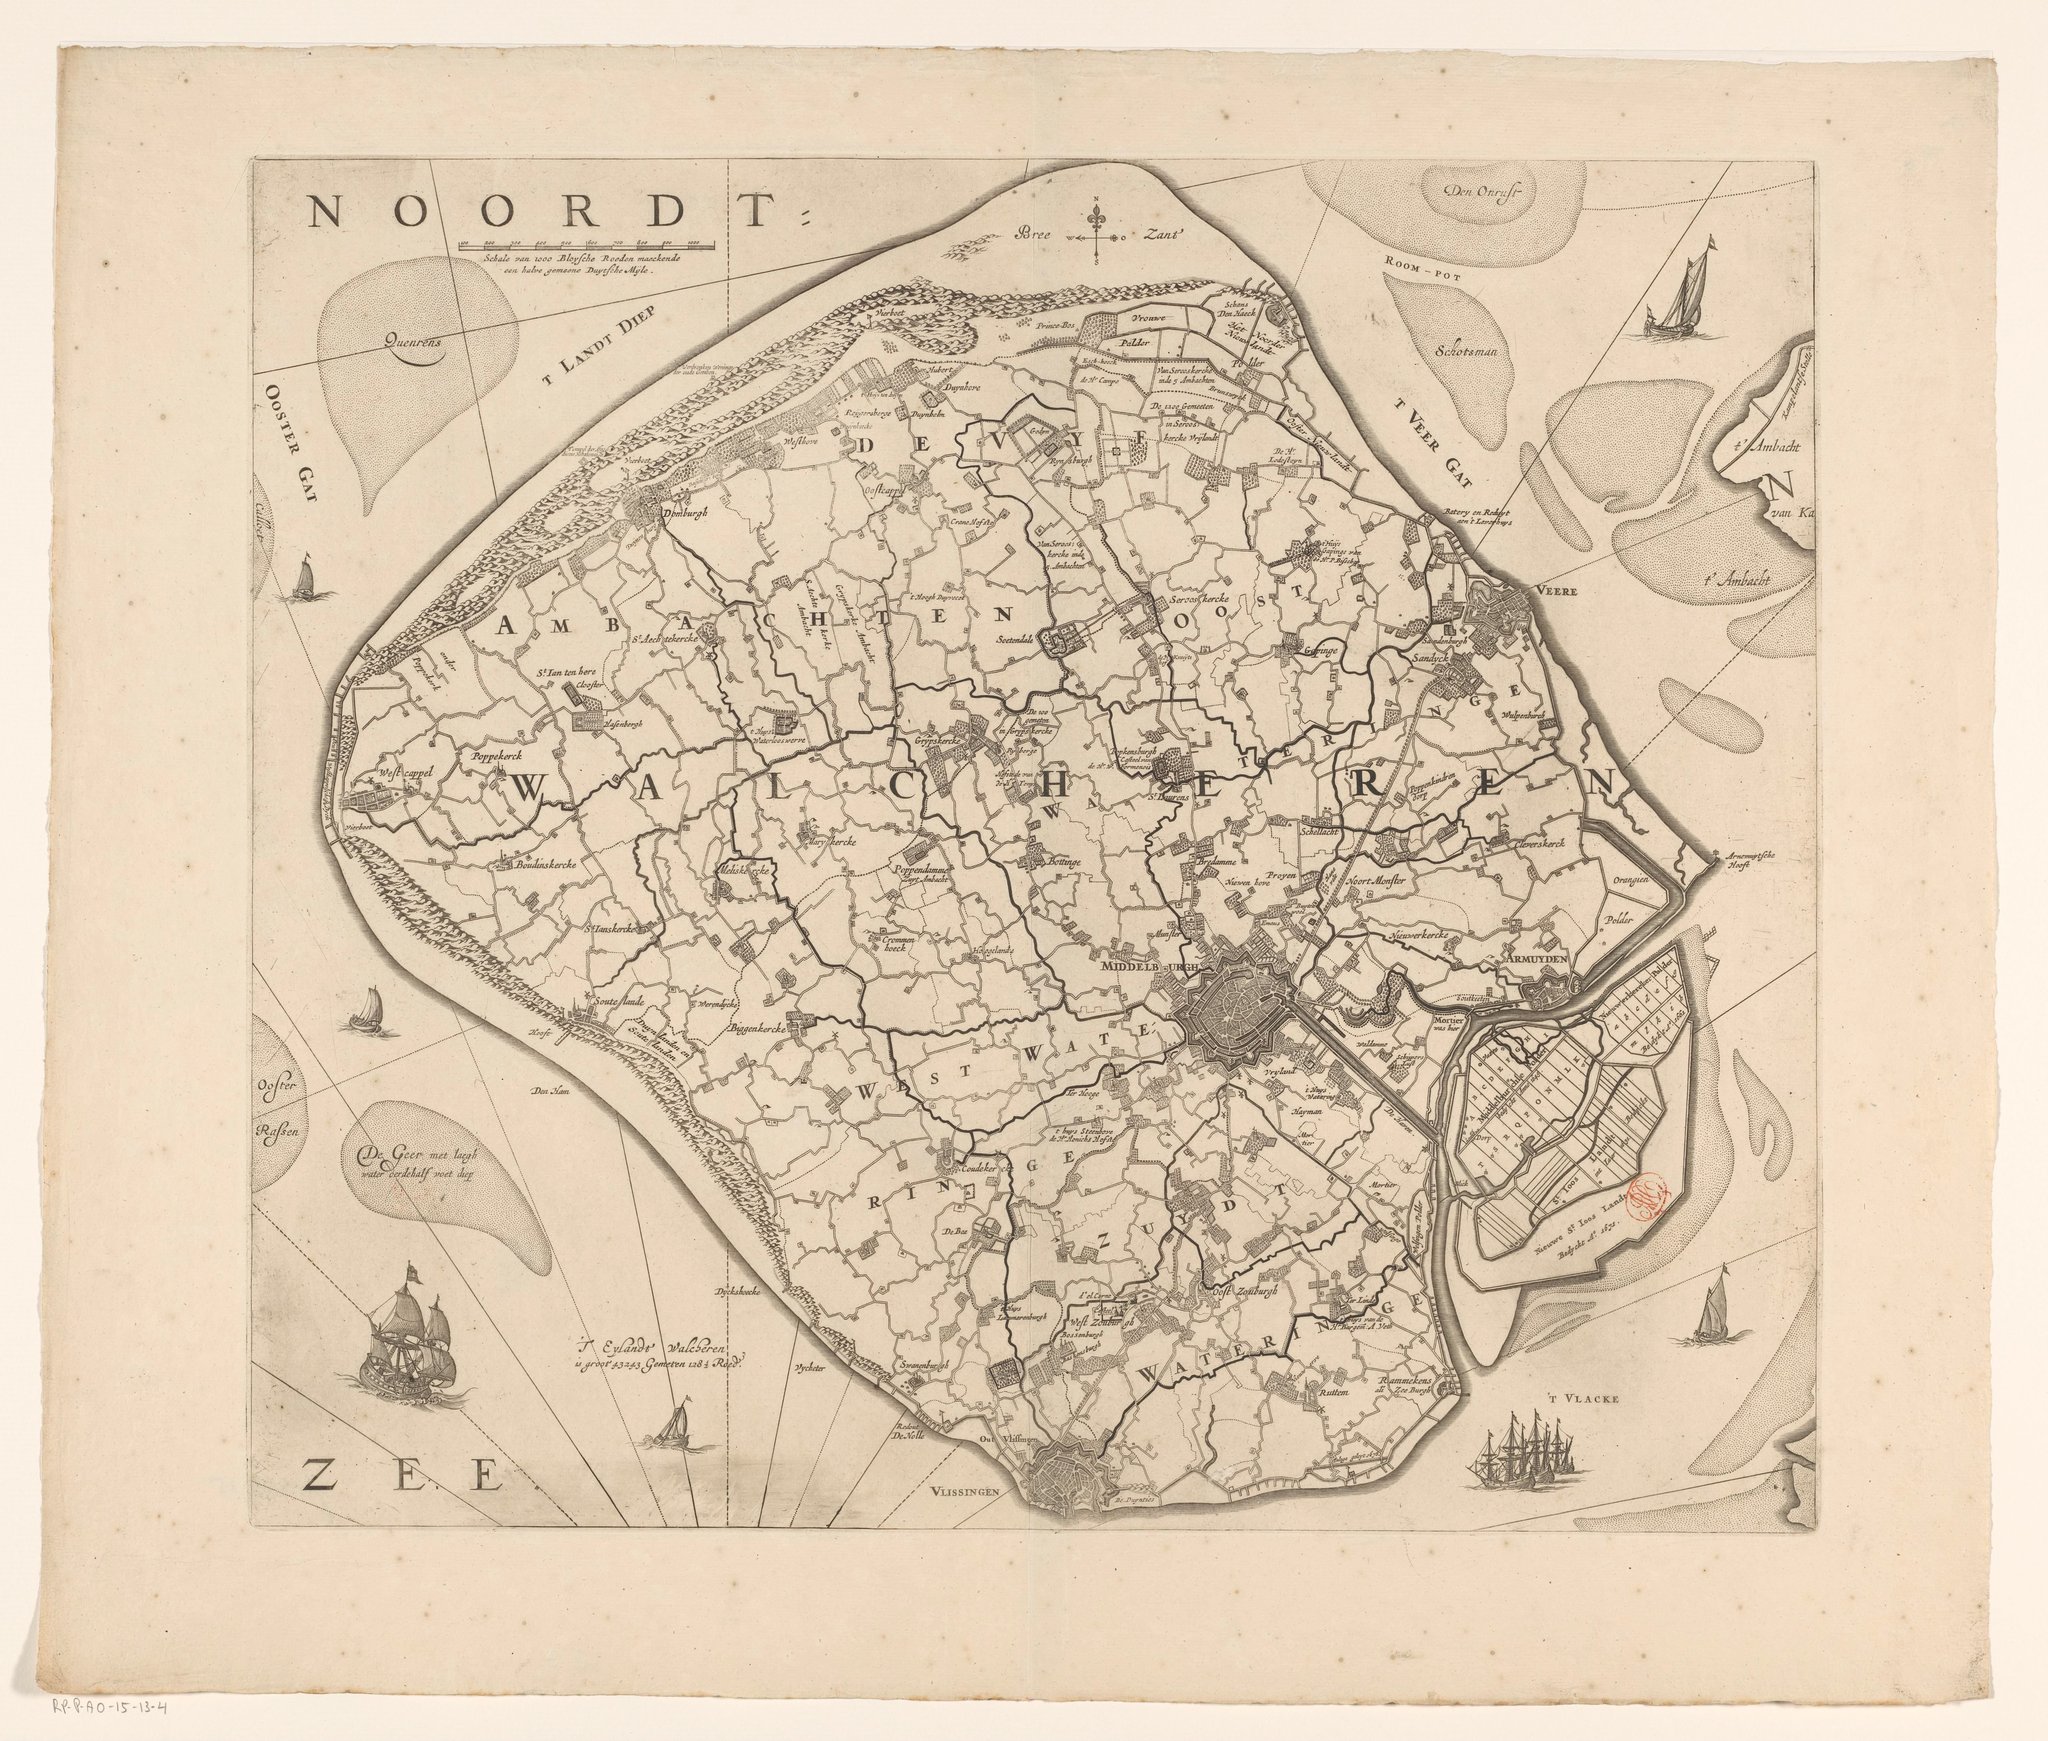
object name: map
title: Kaart van Zeeland (vierde deel)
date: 1655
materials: paper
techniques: engraving, etching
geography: amsterdam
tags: maps of separate countries or regions, zeeland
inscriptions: collector's mark: Lugt 195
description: Vierde deel van een kaart van Zeeland, bestaande uit negen delen. Rechtsonder genummerd: 4.